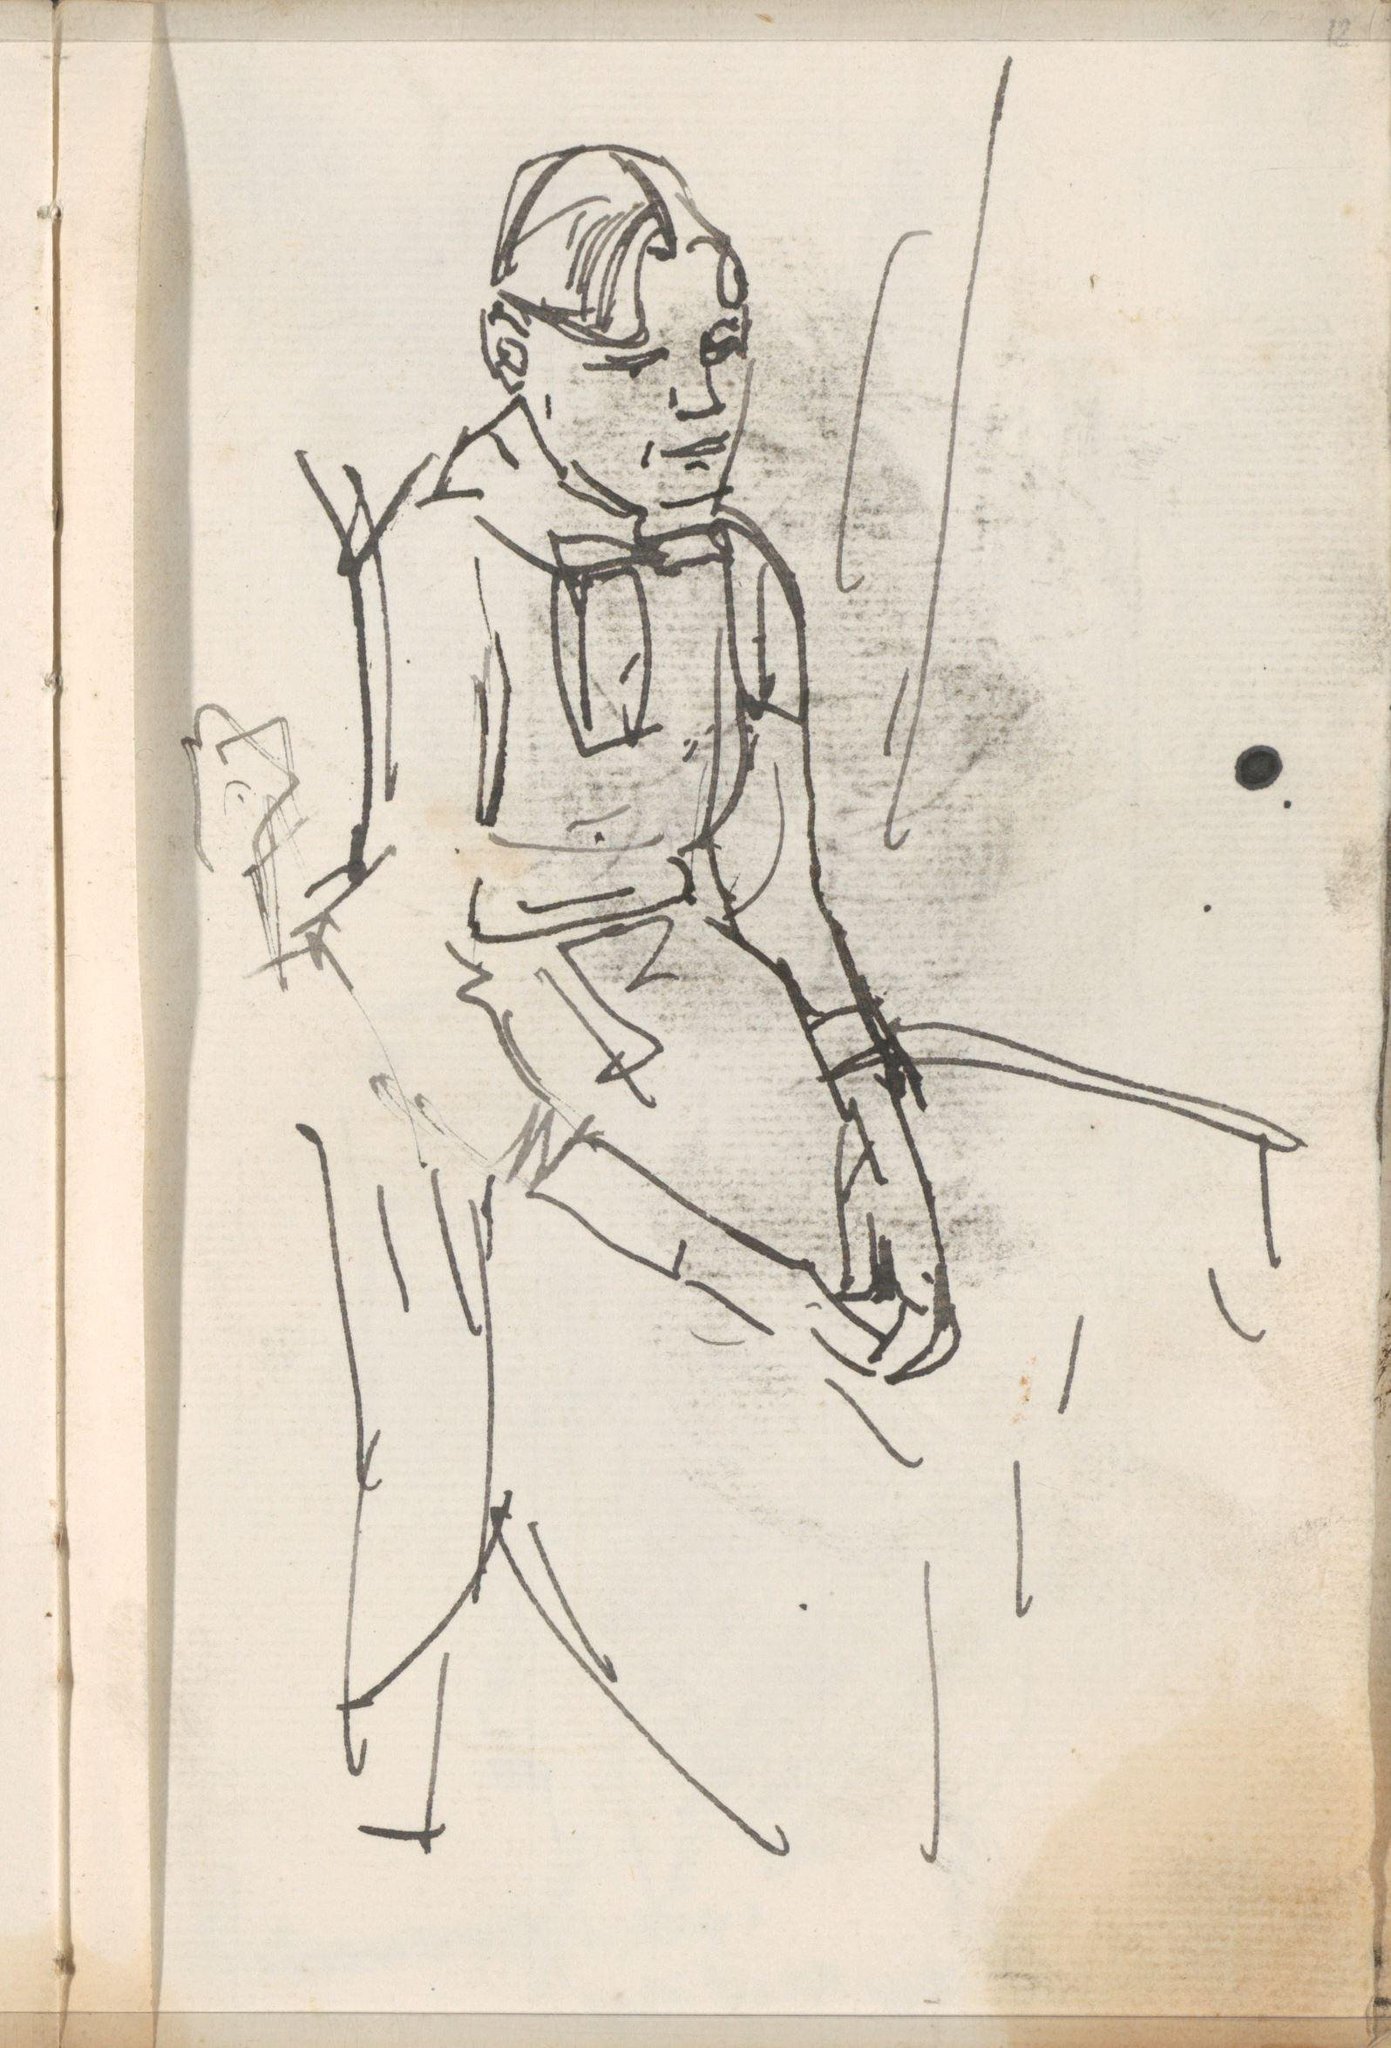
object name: sketchbook leaf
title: Zittende vrouw, mogelijk een dienstmeid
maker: george hendrik breitner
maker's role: draughtsman, painter, print maker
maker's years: 1857-1923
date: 1895-1898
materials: ink, paper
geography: amsterdam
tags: maid ~ house personnel, sitting on an elevation - aa - female human figure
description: Pagina 12 uit een schetsboek met 21 bladen.